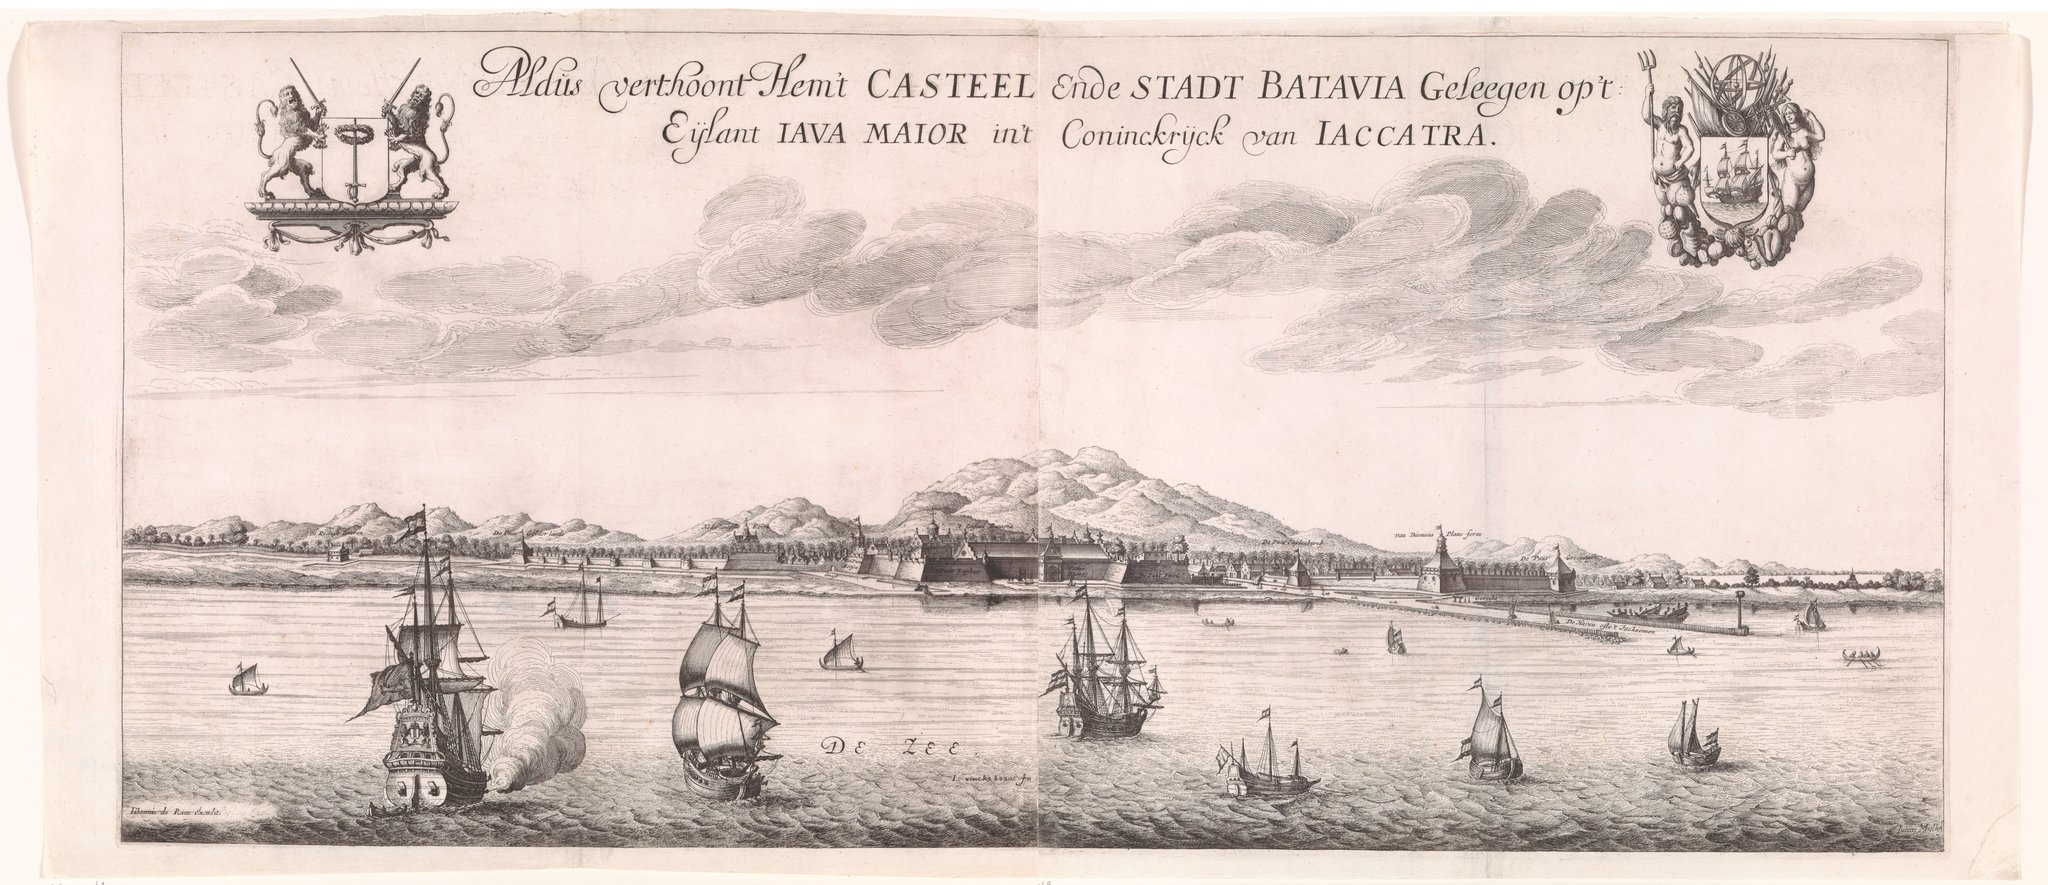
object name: print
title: Gezicht op Batavia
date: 1619-1680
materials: paper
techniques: engraving, etching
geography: amsterdam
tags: harbour, fortress, sailing-ship, sailing-boat, batavia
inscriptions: collector's mark: Lugt 2760, collector's mark: Lugt 2228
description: Gezicht op Batavia met in het midden kasteel Batavia, omgeven door zijn bastions. Op de voorgrond zeilschepen van de VOC. Linksboven het wapenschild van de stad Batavia, rechtsboven een wapenschild met een schip, vermoedelijk van de Verenigde Oost-Indische Compagnie.